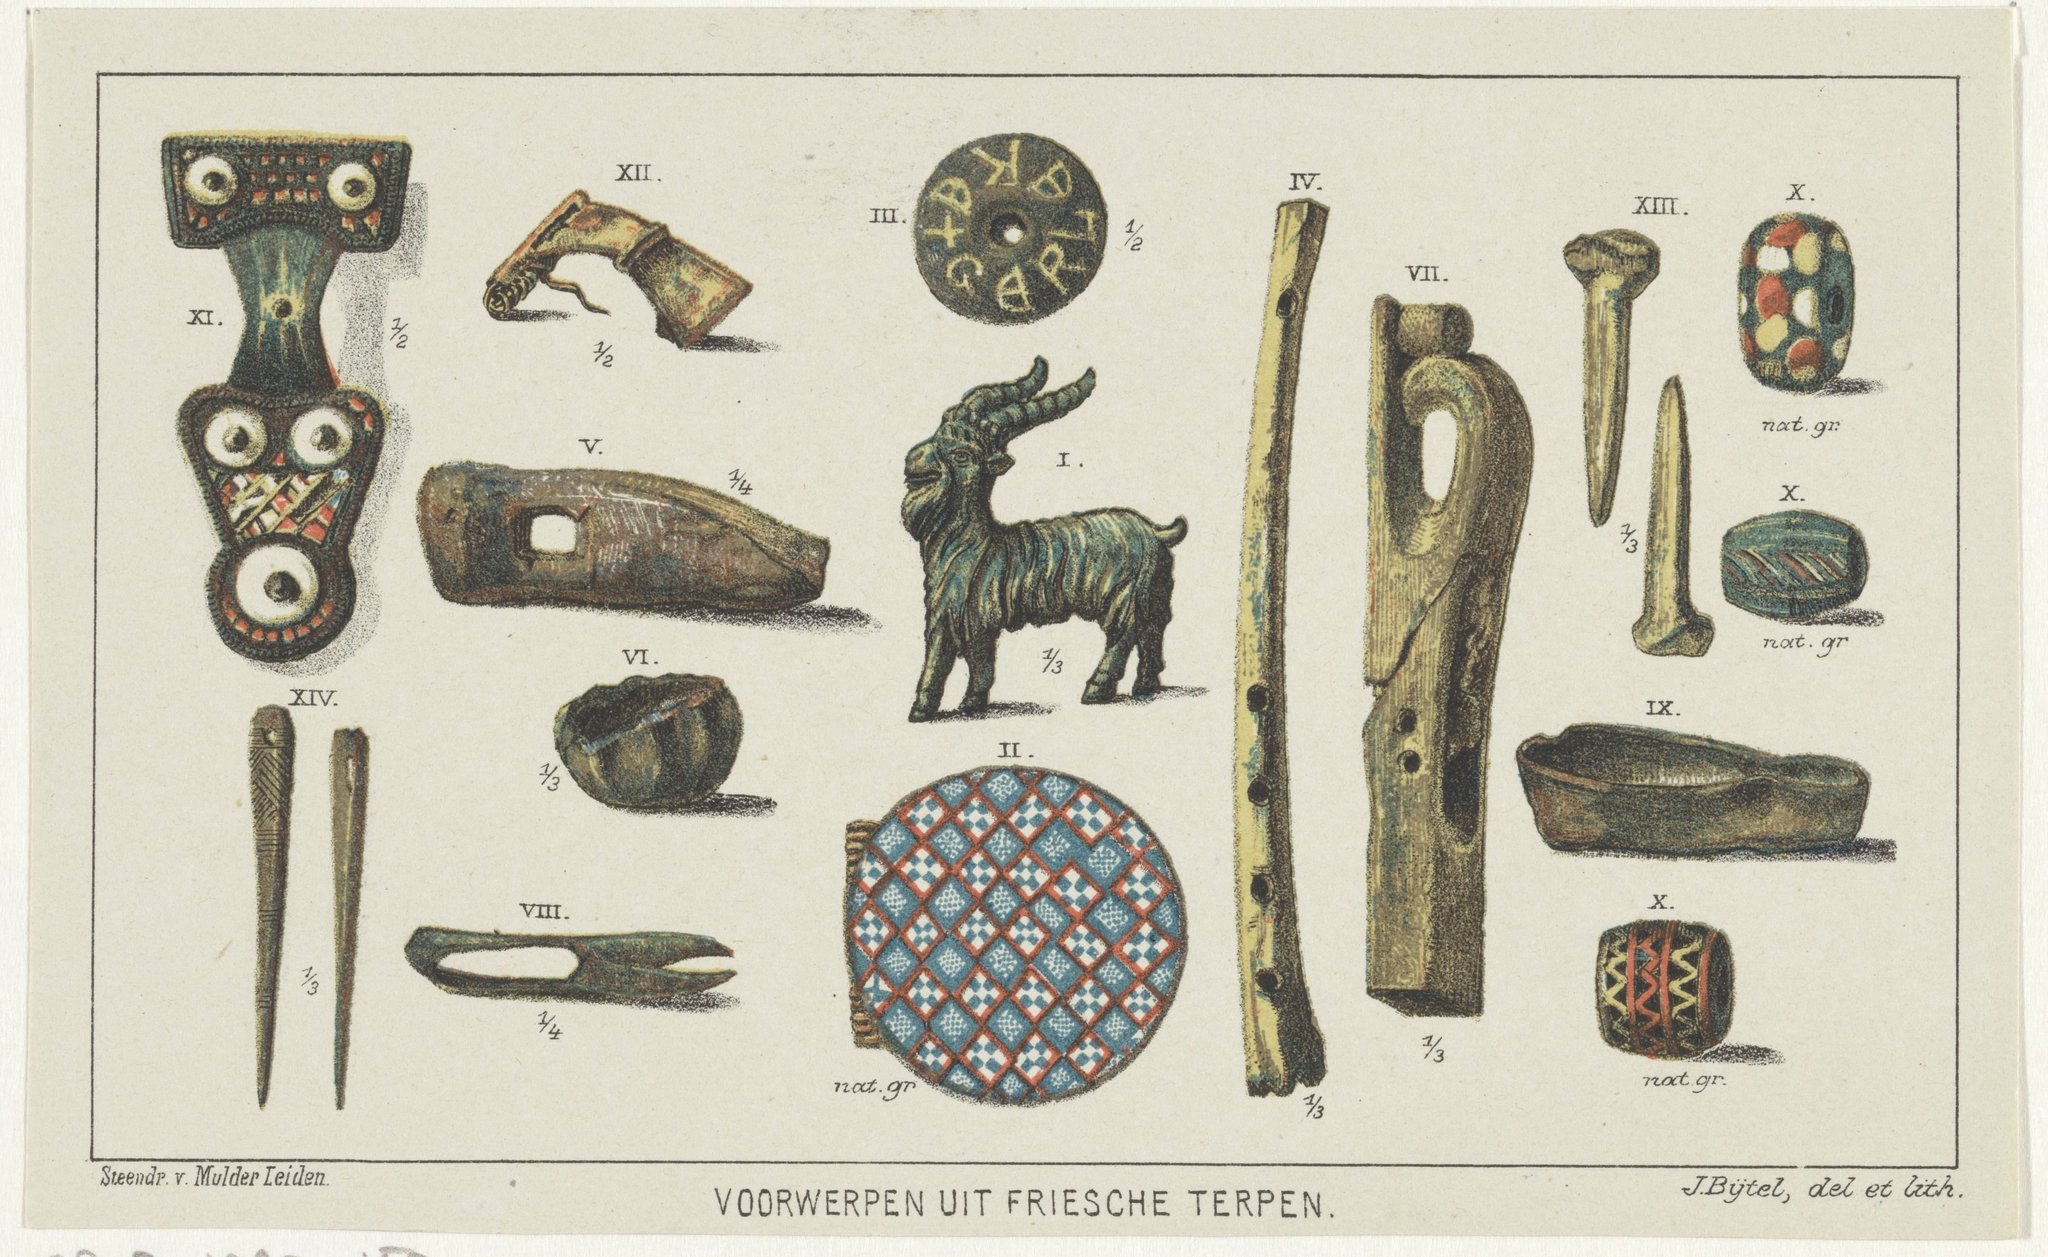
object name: print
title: Voorwerpen uit Friesche terpen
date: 1869-1916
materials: paper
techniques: chromolithography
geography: netherlands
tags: he-goat, billy-goat, excavation ~ archaeology, (household) utensils and implements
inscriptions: collector's mark: Lugt 2760, collector's mark: Lugt 2228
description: Afgebeeld zijn achttien losse voorwerpen zoals twee naalden, spijkers, een sculptuur van een bok en een kom. Verschenen in het Friesche Volksalmanak in 1886.